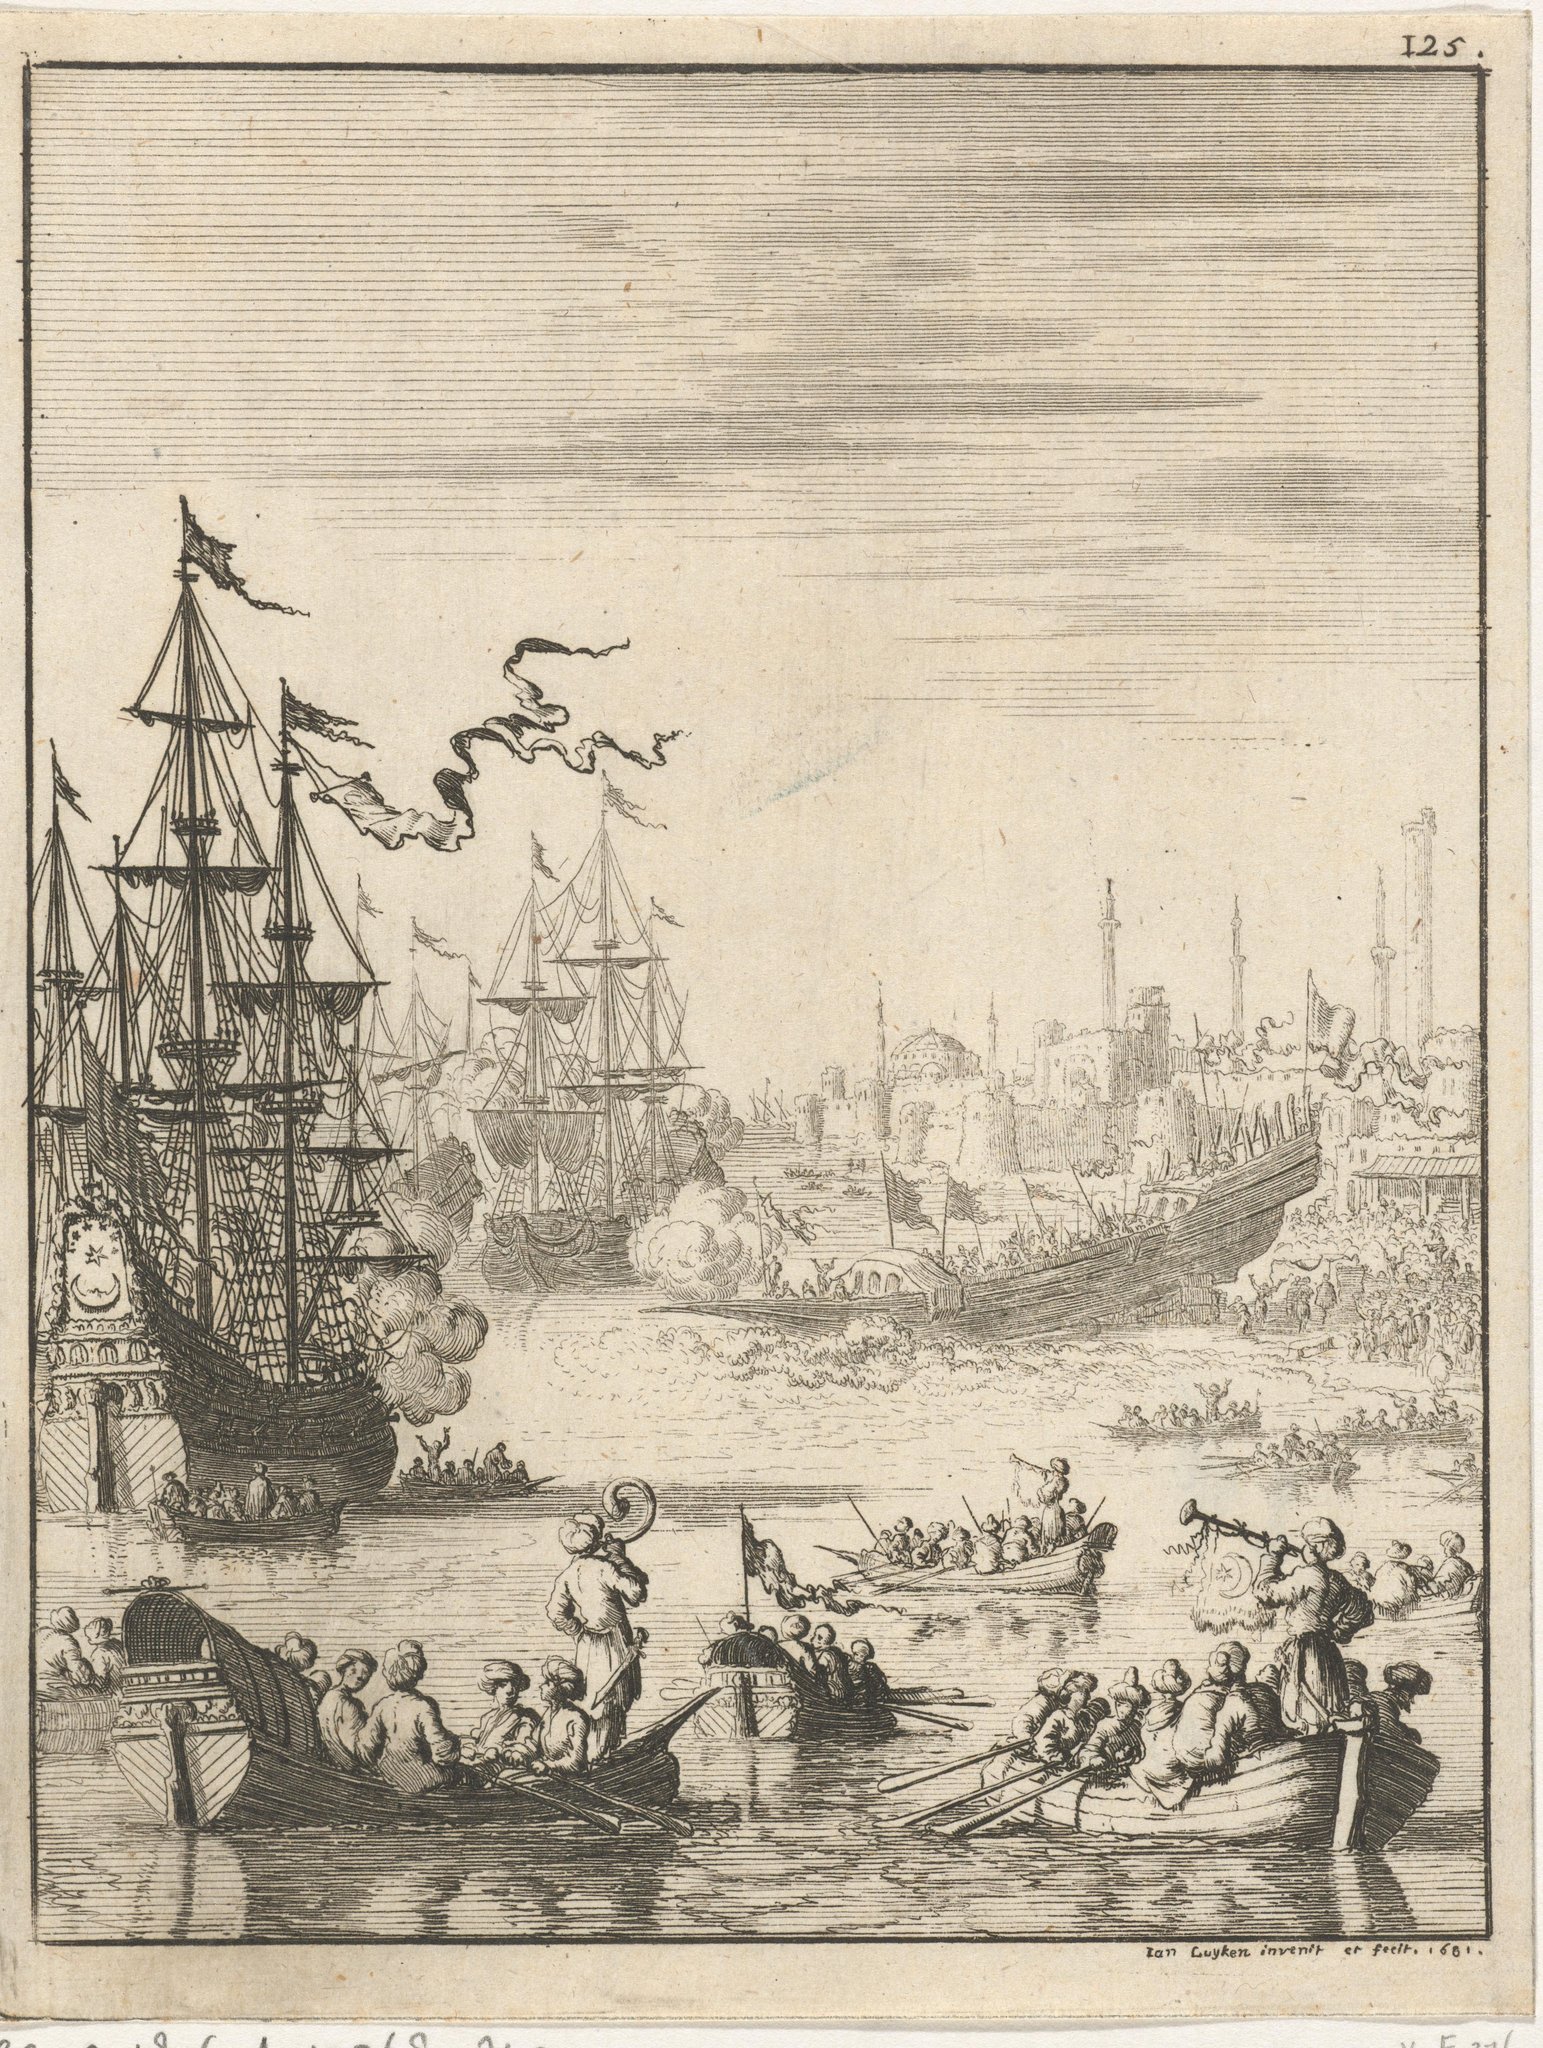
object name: book illustration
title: Turkse galei wordt te water gelaten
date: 1681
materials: paper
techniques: etching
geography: amsterdam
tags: launching a ship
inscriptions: collector's mark: Lugt 2228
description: Illustratie opgenomen in deel I van: Thevenot, Jean de. Gedenkwaardige en zeer naauwkeurige reizen van den heere de Thevenot. Amsterdam: Jan Bouman, 1681-1682.